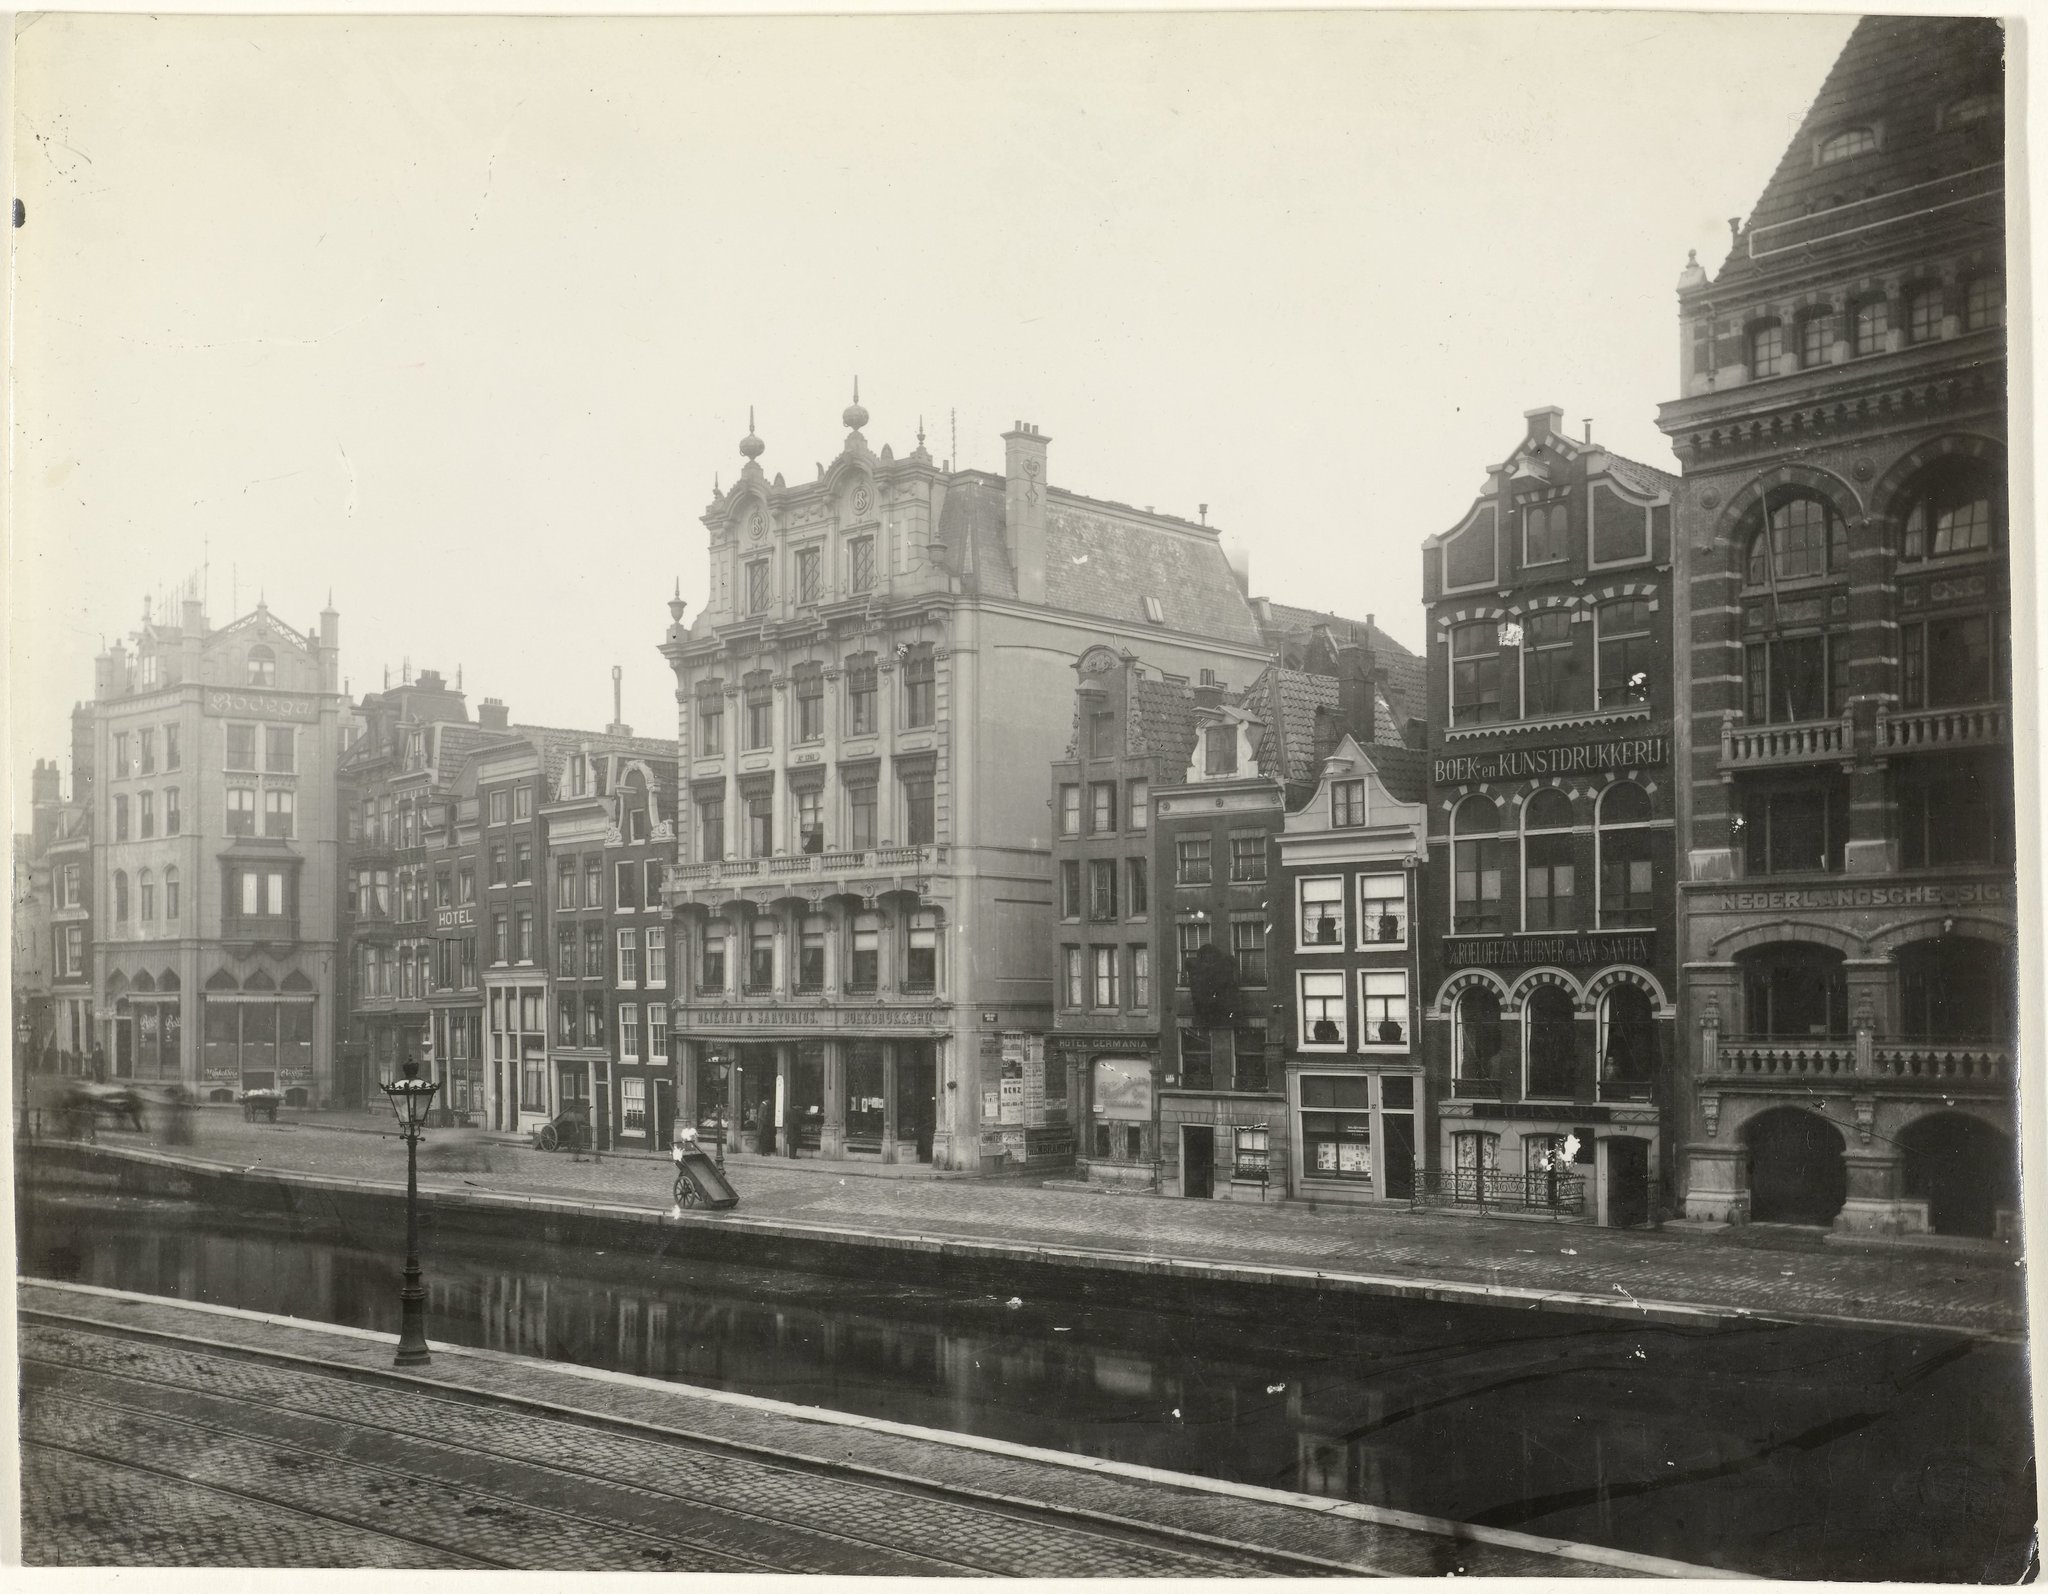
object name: photograph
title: Gezicht op het Rokin voor demping in Amsterdam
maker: Anonymous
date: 1880-1930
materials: photographic support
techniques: gelatin silver print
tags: rokin